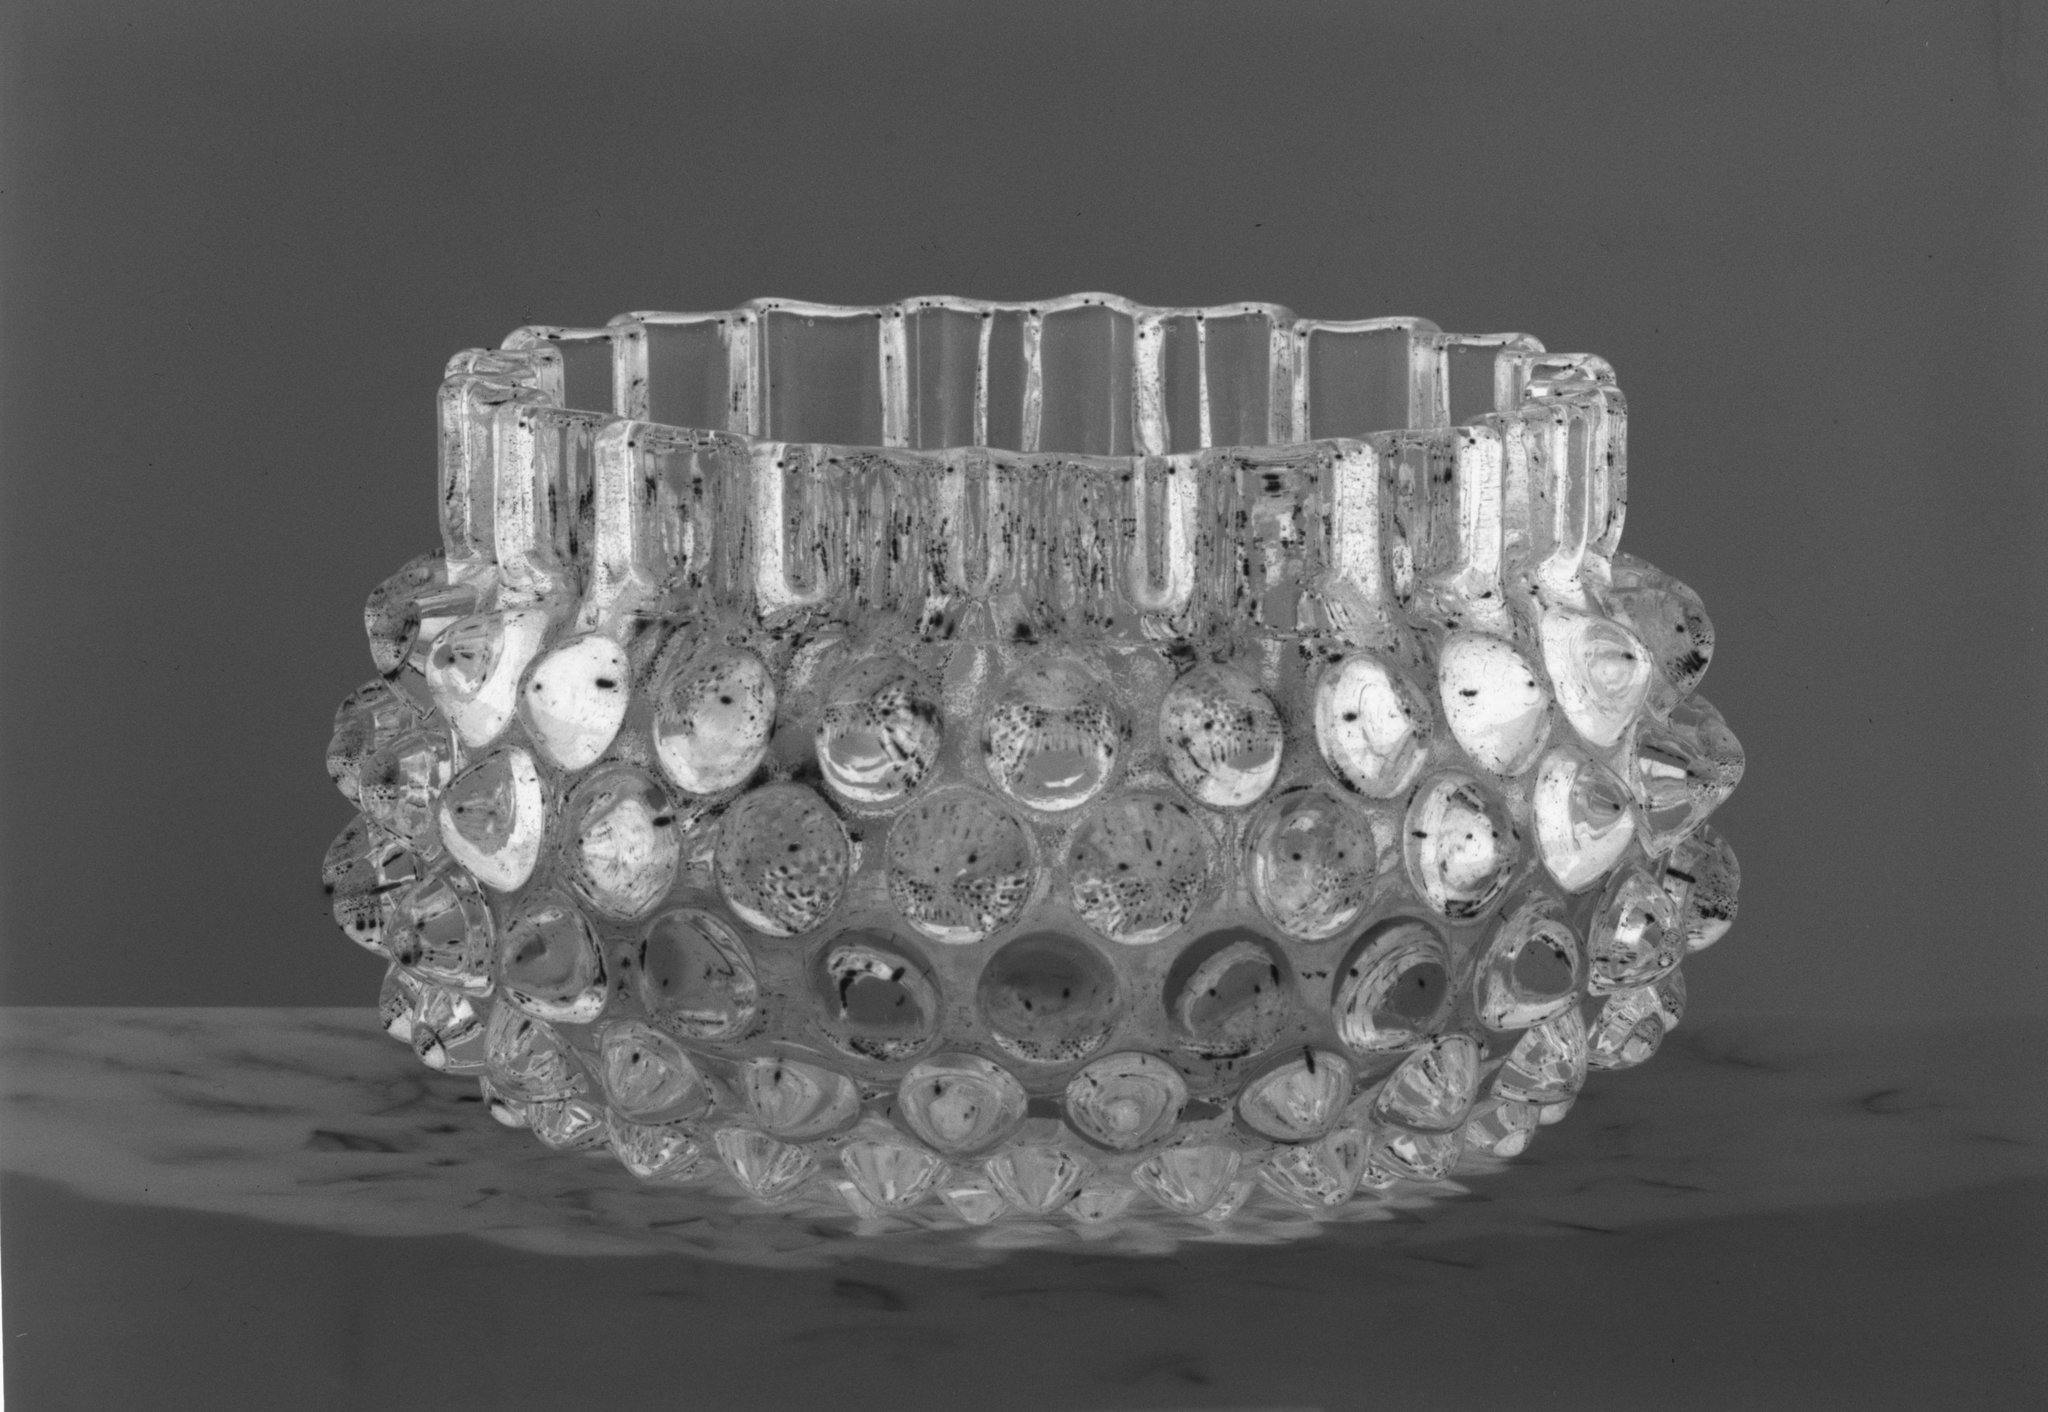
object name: finger bowl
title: Hobnail Finger Bowl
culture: american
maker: hobbs, brockunier and company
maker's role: maker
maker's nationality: american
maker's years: 1863-1891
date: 1886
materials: glass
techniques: pressed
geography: united states